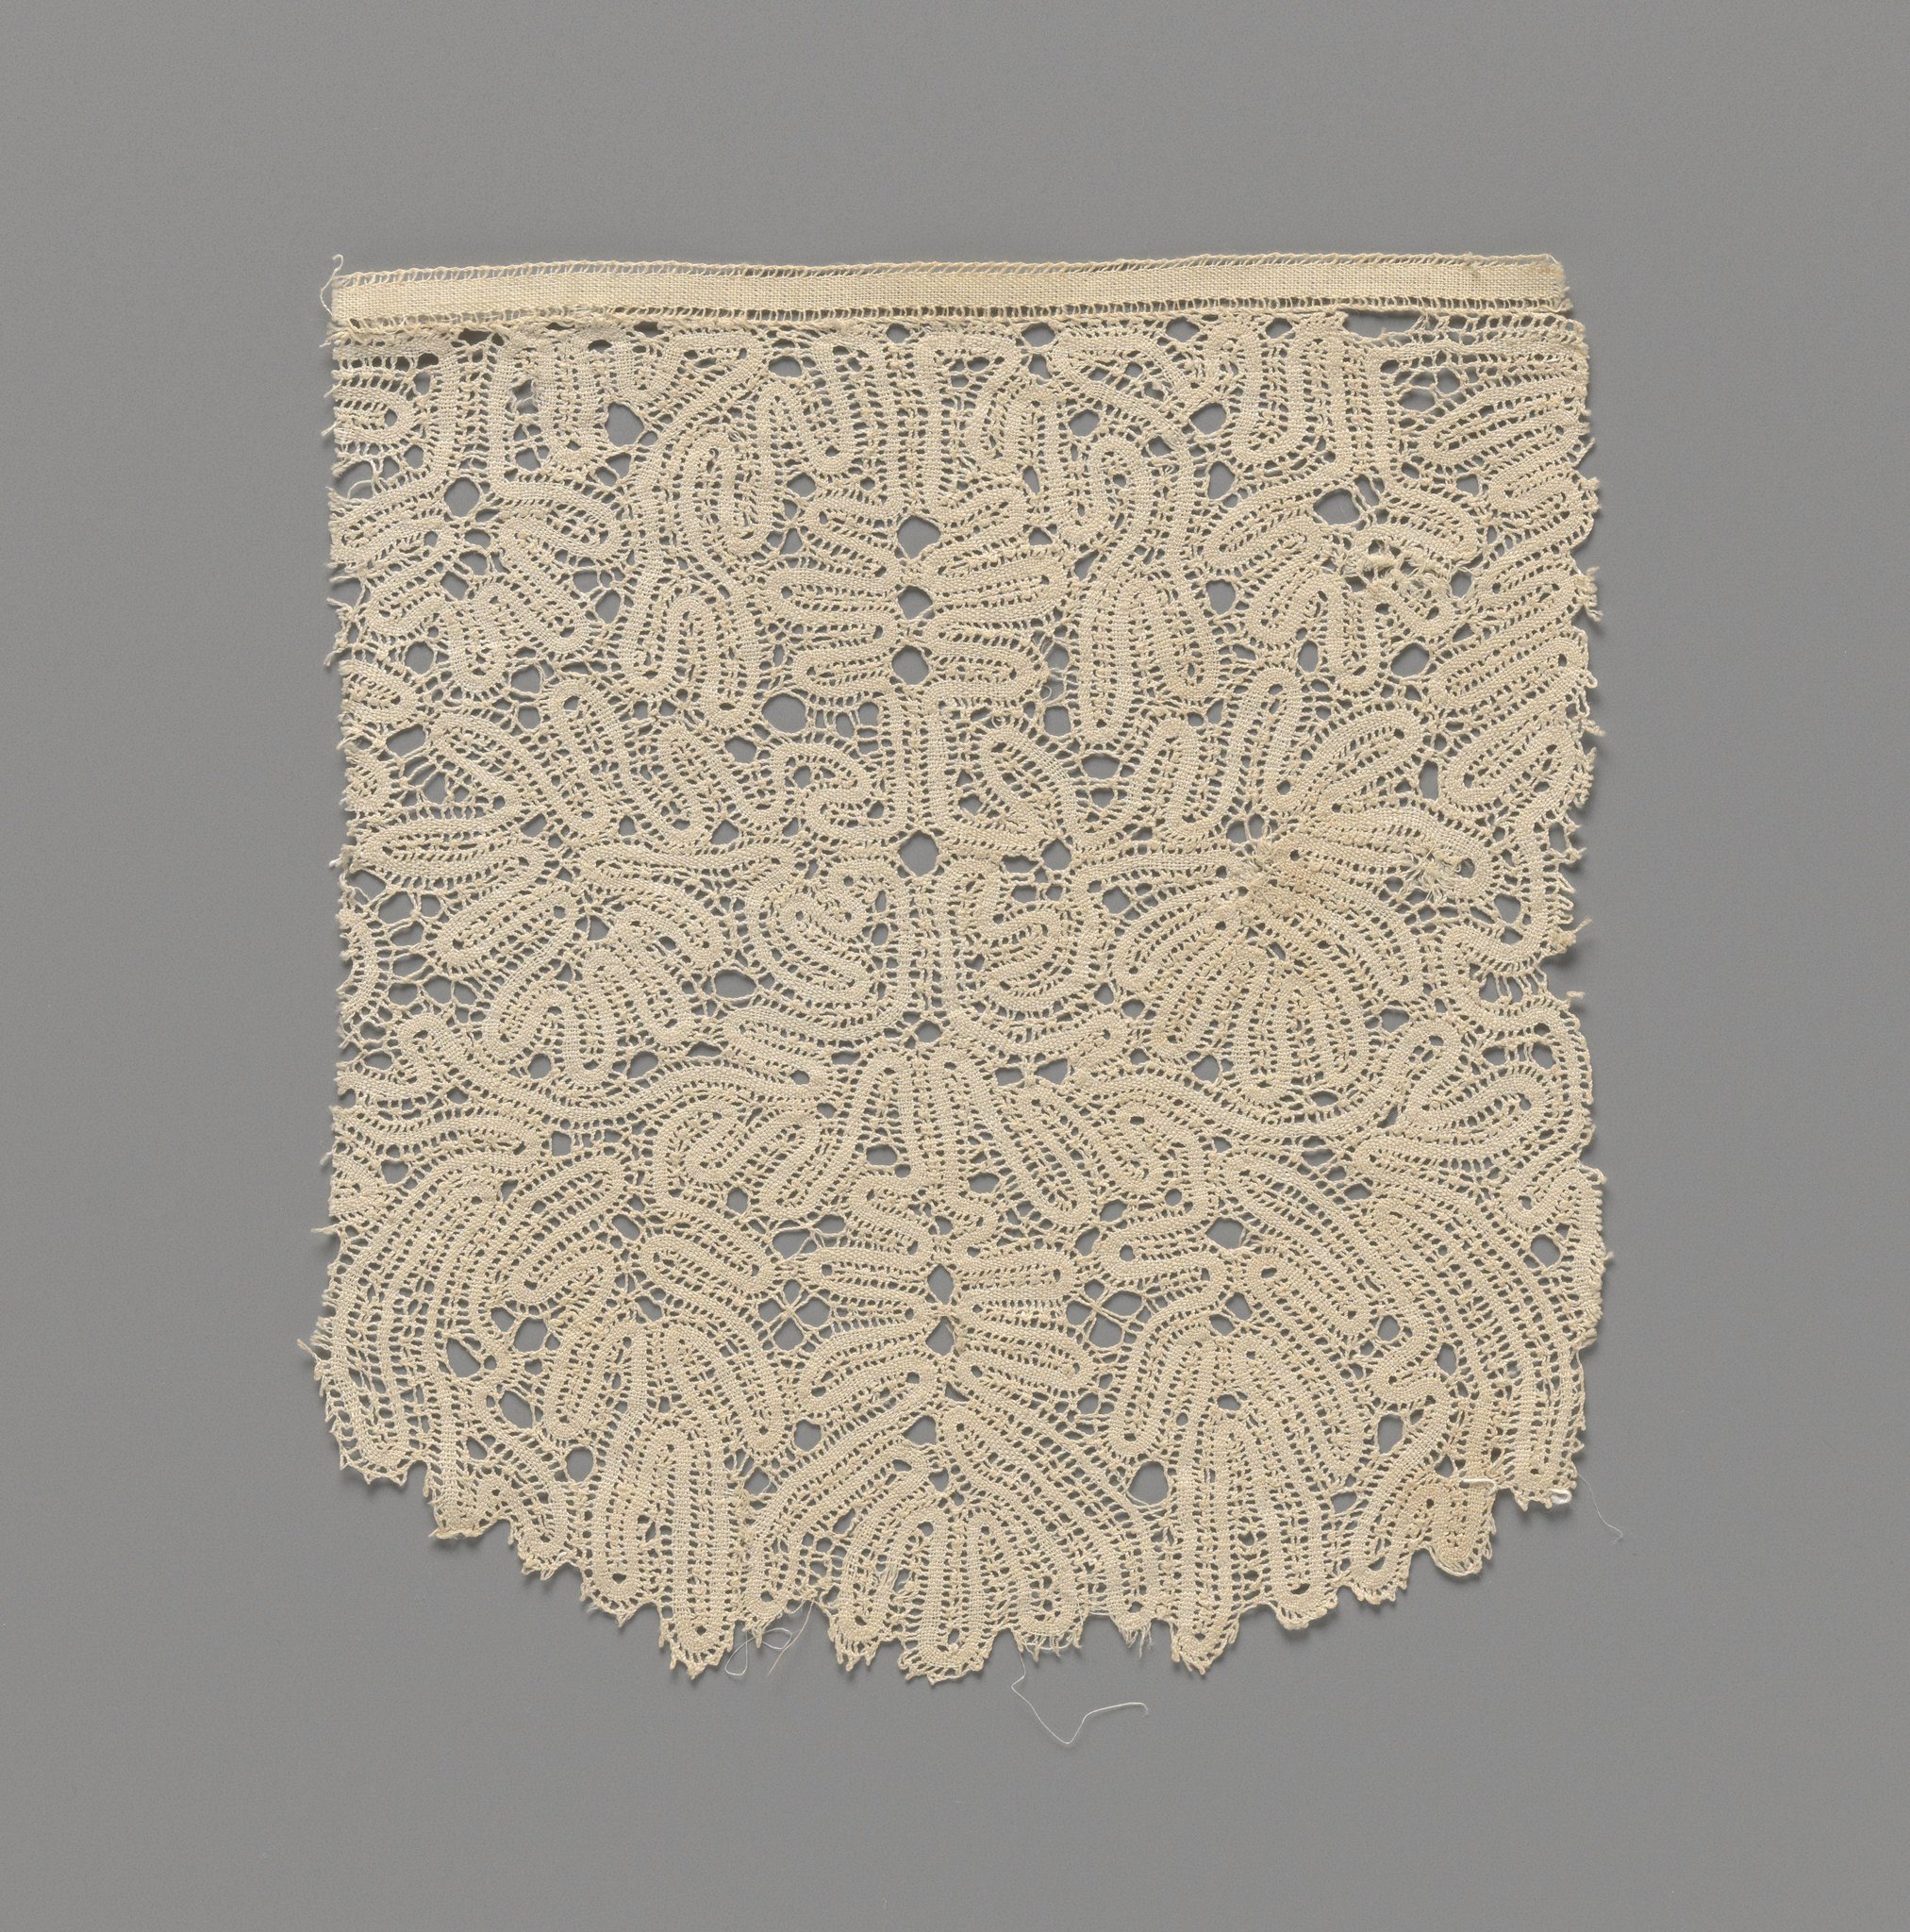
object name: strip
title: Strook kloskant met kandelabermotief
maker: Anonymous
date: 1880-1899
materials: linen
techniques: lace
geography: abruzzo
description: Strook naturelkleurige kloskant: Oosteuropese kant. Het patroon bestaat uit een symmetrische compositie waarbij de contouren van de motieven zijn gemaakt met een doorlopend smal lint dat sterk kronkeld. De compositie bestaat uit een kandelabermotief met aan weerszijden in het midden een bloem met negen smalle bloembladen. Onder de bloemen afhangende bladeren. De linten zijn gemaakt in linnenslag met opengewerkte randjes en met zeven paar klossen. De motieven zijn met elkaar verbonden doordat het lopende paar van het lint na een bocht telkens aan het voorgaande wordt ingehaakt. Het kant is met alle klosjes tegelijk gewerkt. De bovenzijde van de strook is recht afgewerkt. Het kronkelende lint zorgt voor een schulpenrand langs de onderzijde van de strook en is afgewerkt met picots.